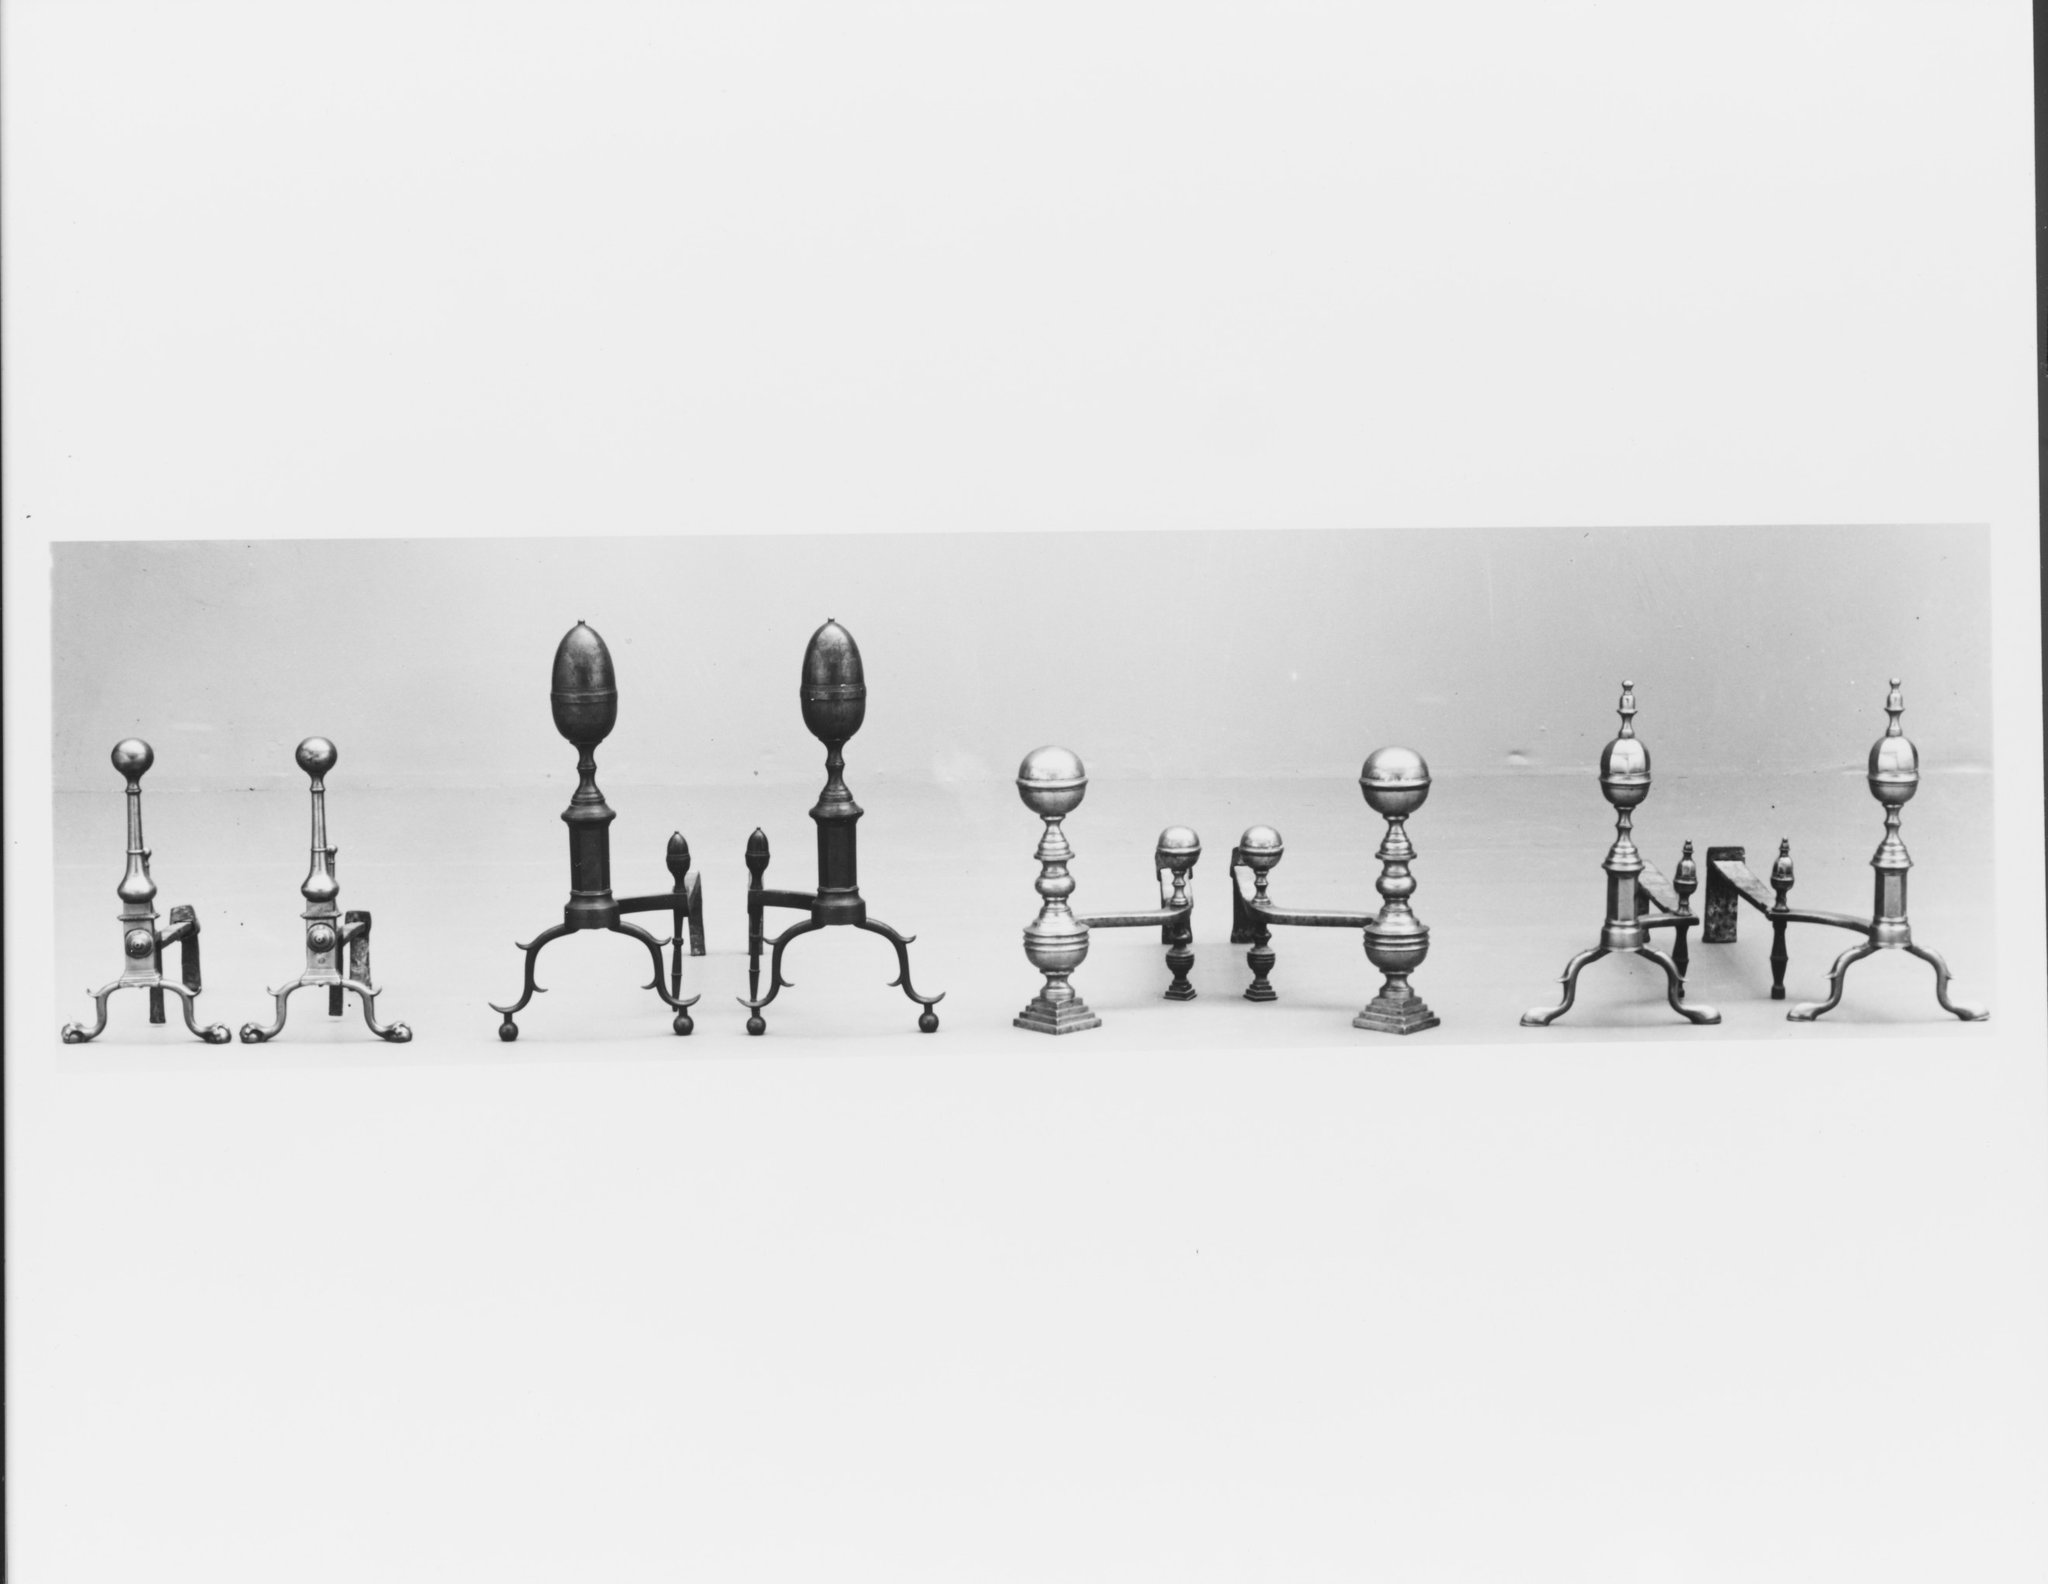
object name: andiron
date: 1700-1800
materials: metal